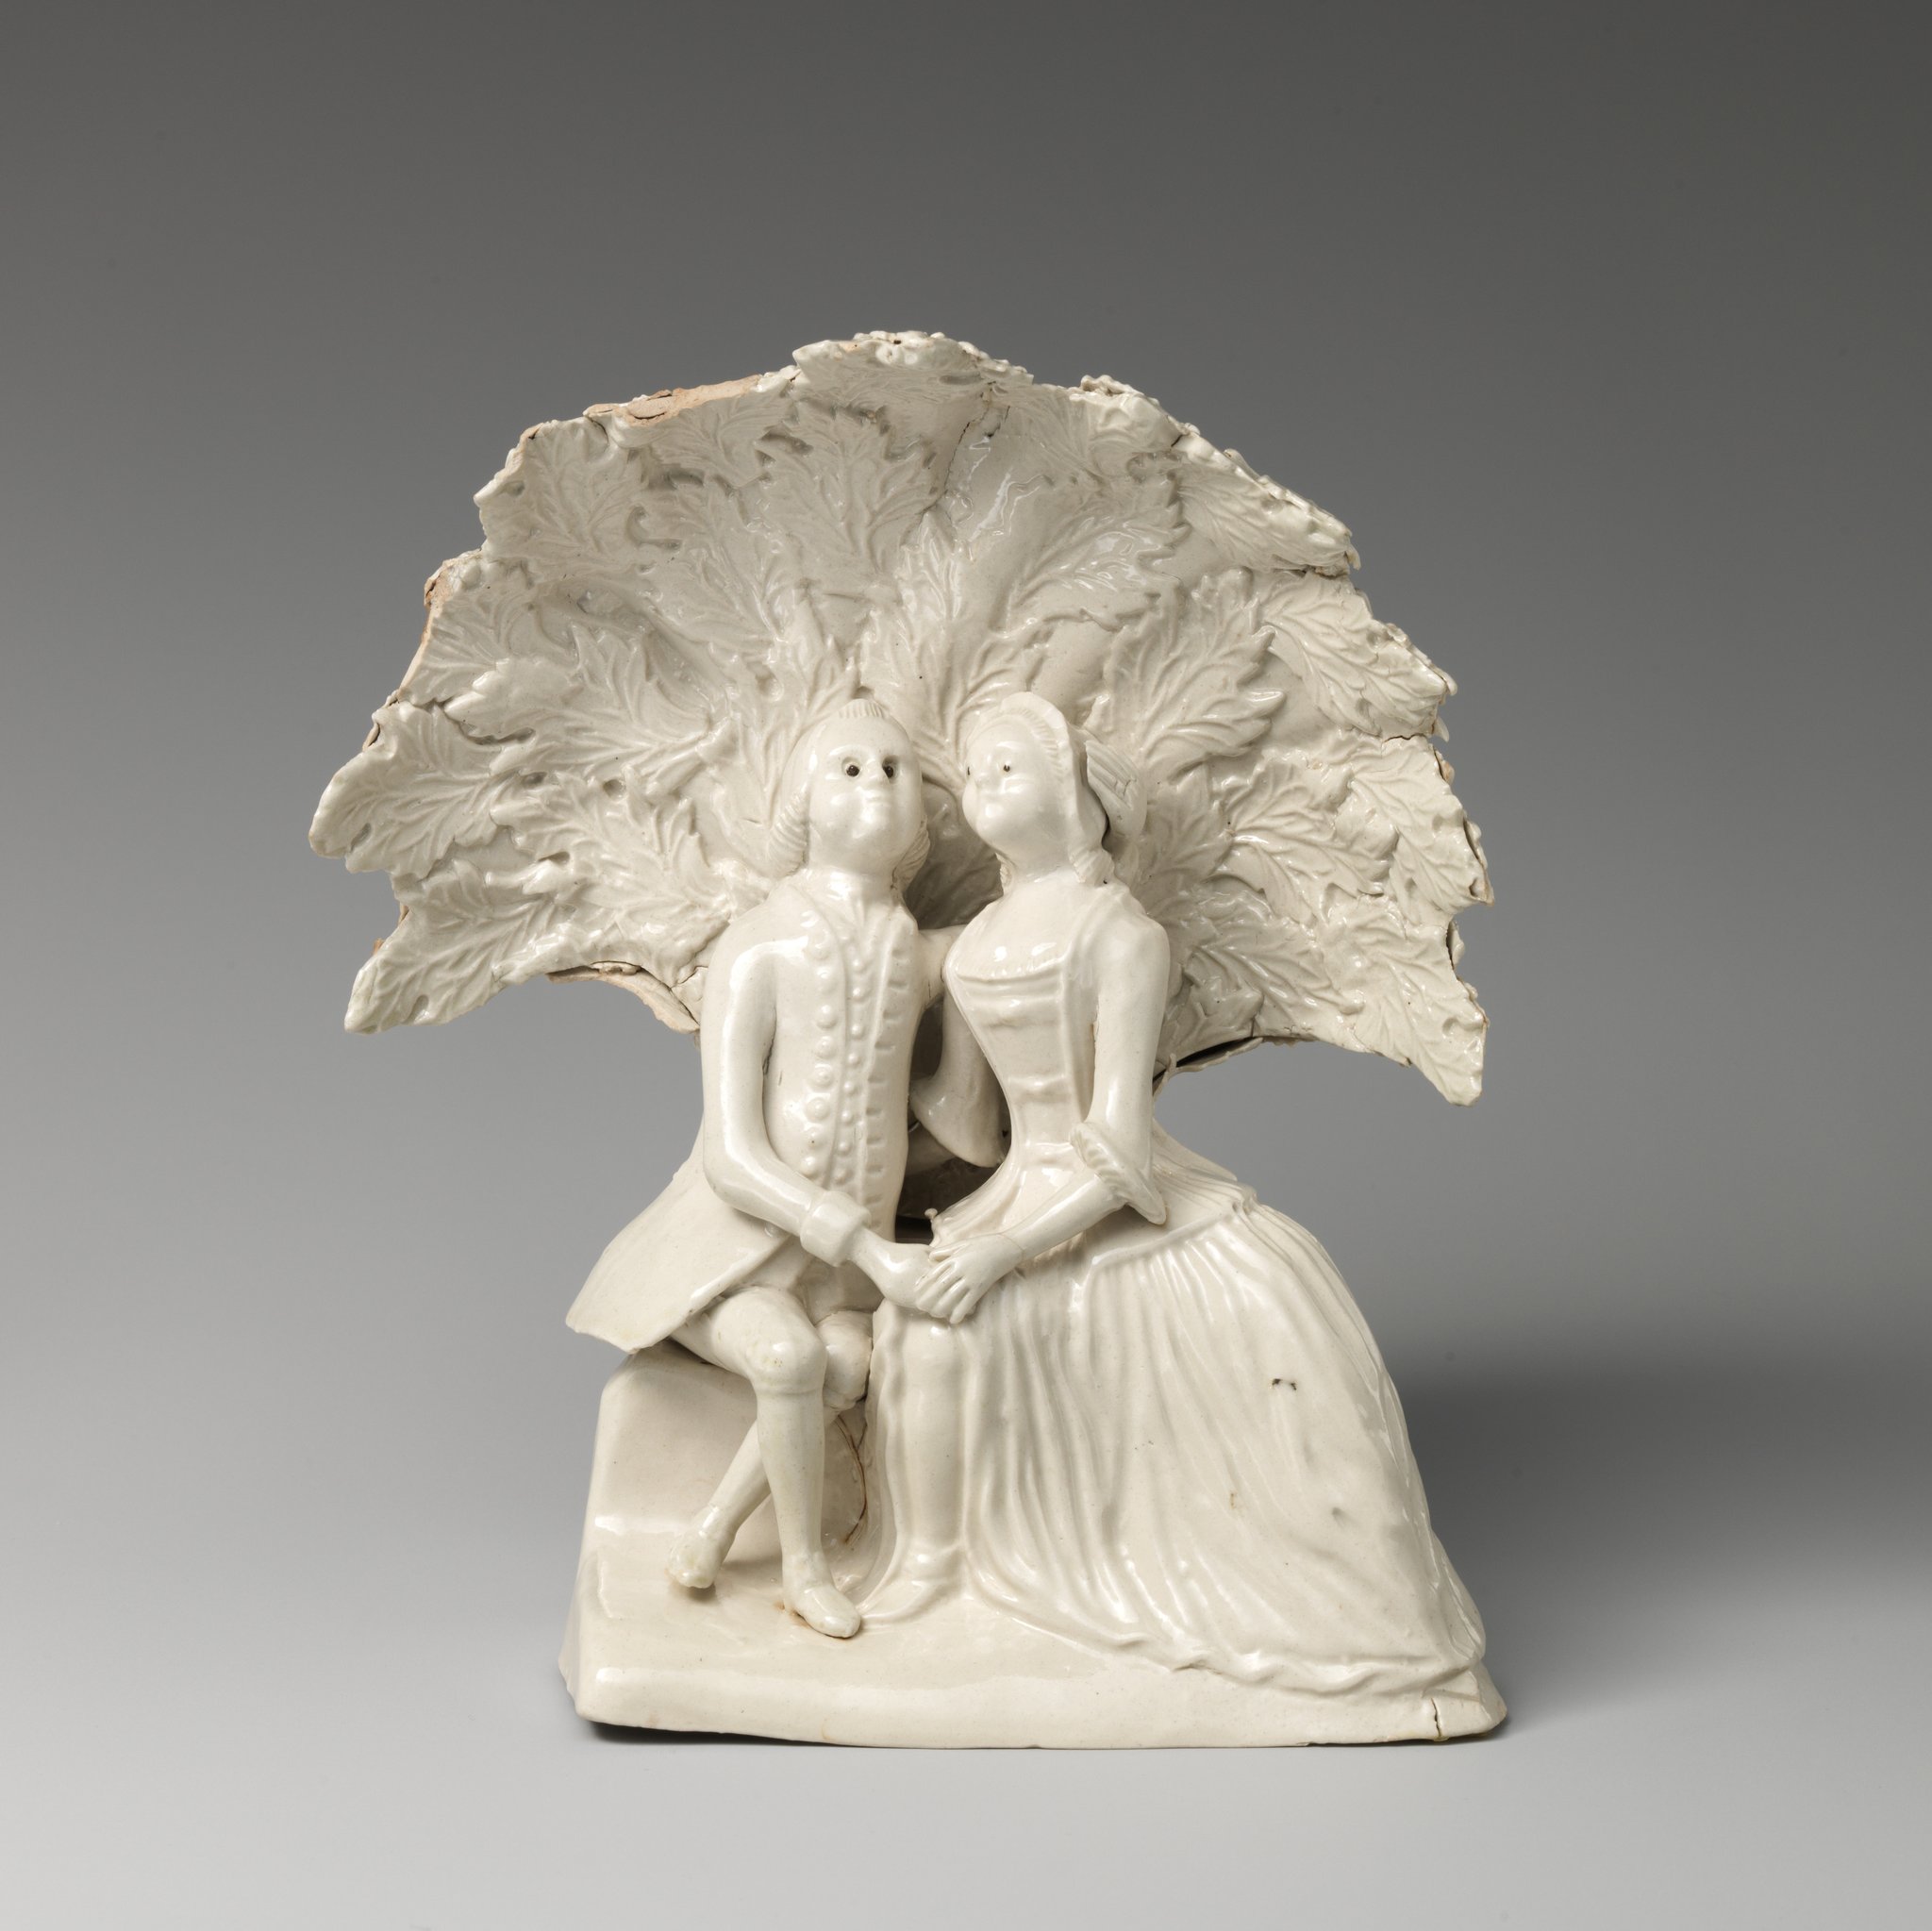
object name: figure group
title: Arbor group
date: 1750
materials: stoneware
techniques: salt glaze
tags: couples,men,women